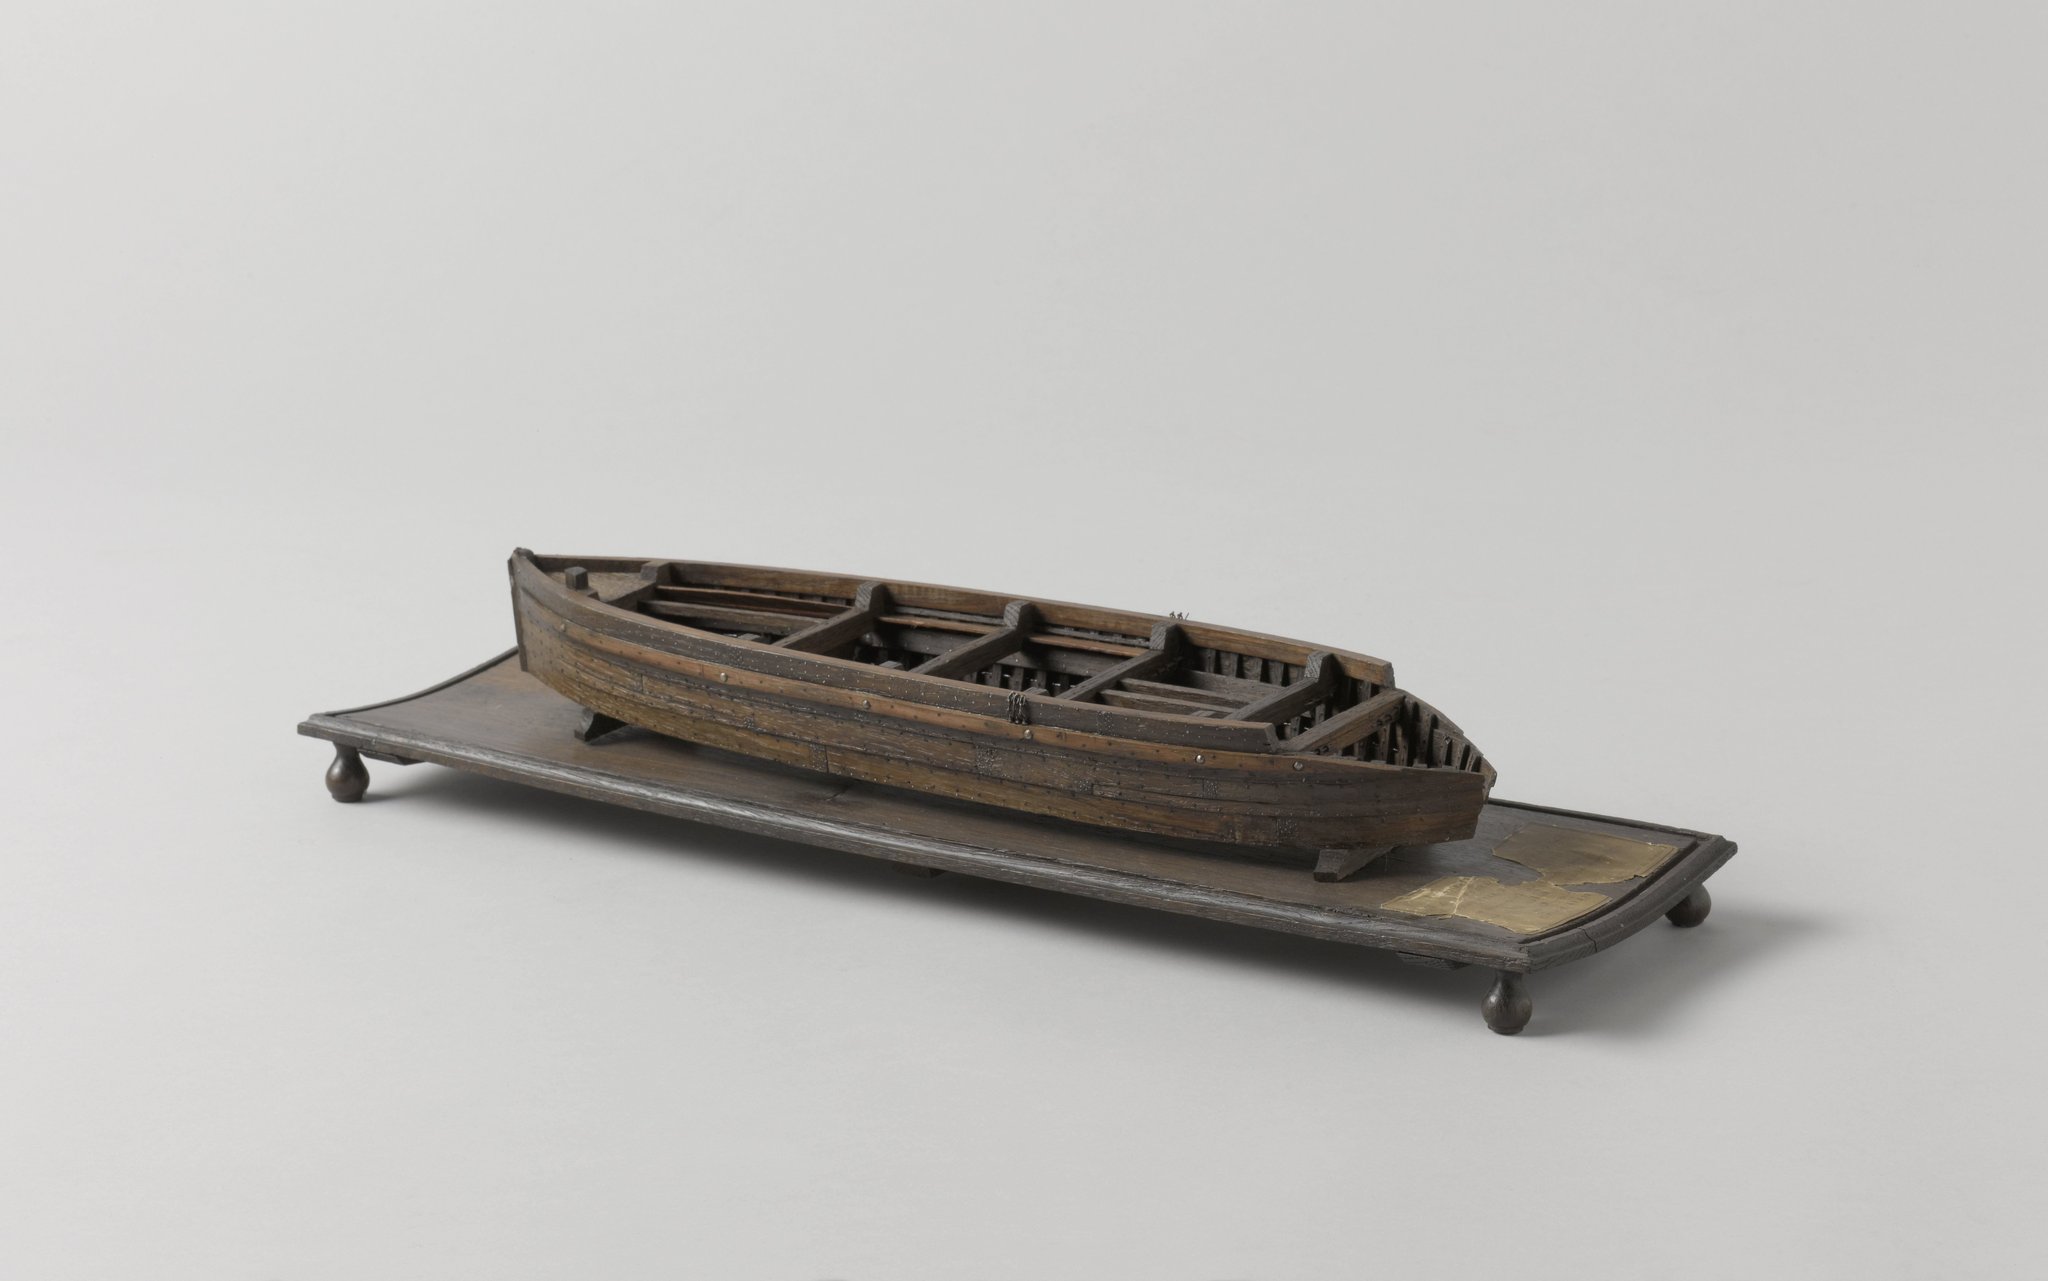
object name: reconstruction model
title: Model of an Excavated Boat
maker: cornelis jan glavimans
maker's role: scheepsbouwer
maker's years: 1796-1857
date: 1822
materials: wood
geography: rotterdam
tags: geertruidenberg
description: Vrij grof model van een eenmastschip zonder tuig. Het is een overnaadse platbodem spitsgatter met rechte, vallende stevens. Dekbalken geven een hoofddek aan, en het model heeft een voor- en achterplecht met luiken. Op het achterplecht staat een braadspil, op het voorplecht twee pompbuizen. In het ruim is achter een deel afgeschot. De zeeg loopt op naar beide uiteinden, het model heeft één barkhout. Van het tuig zijn een mastspoor, een masthouder en kettingputtings aangegeven. Het model is een reconstructie van het vaartuig dat op 22 februari 1822 te Capelle in de Langstraat werd ontdekt en vervolgens opgegraven. Het is geheel gemaakt van materiaal van het originele schip.